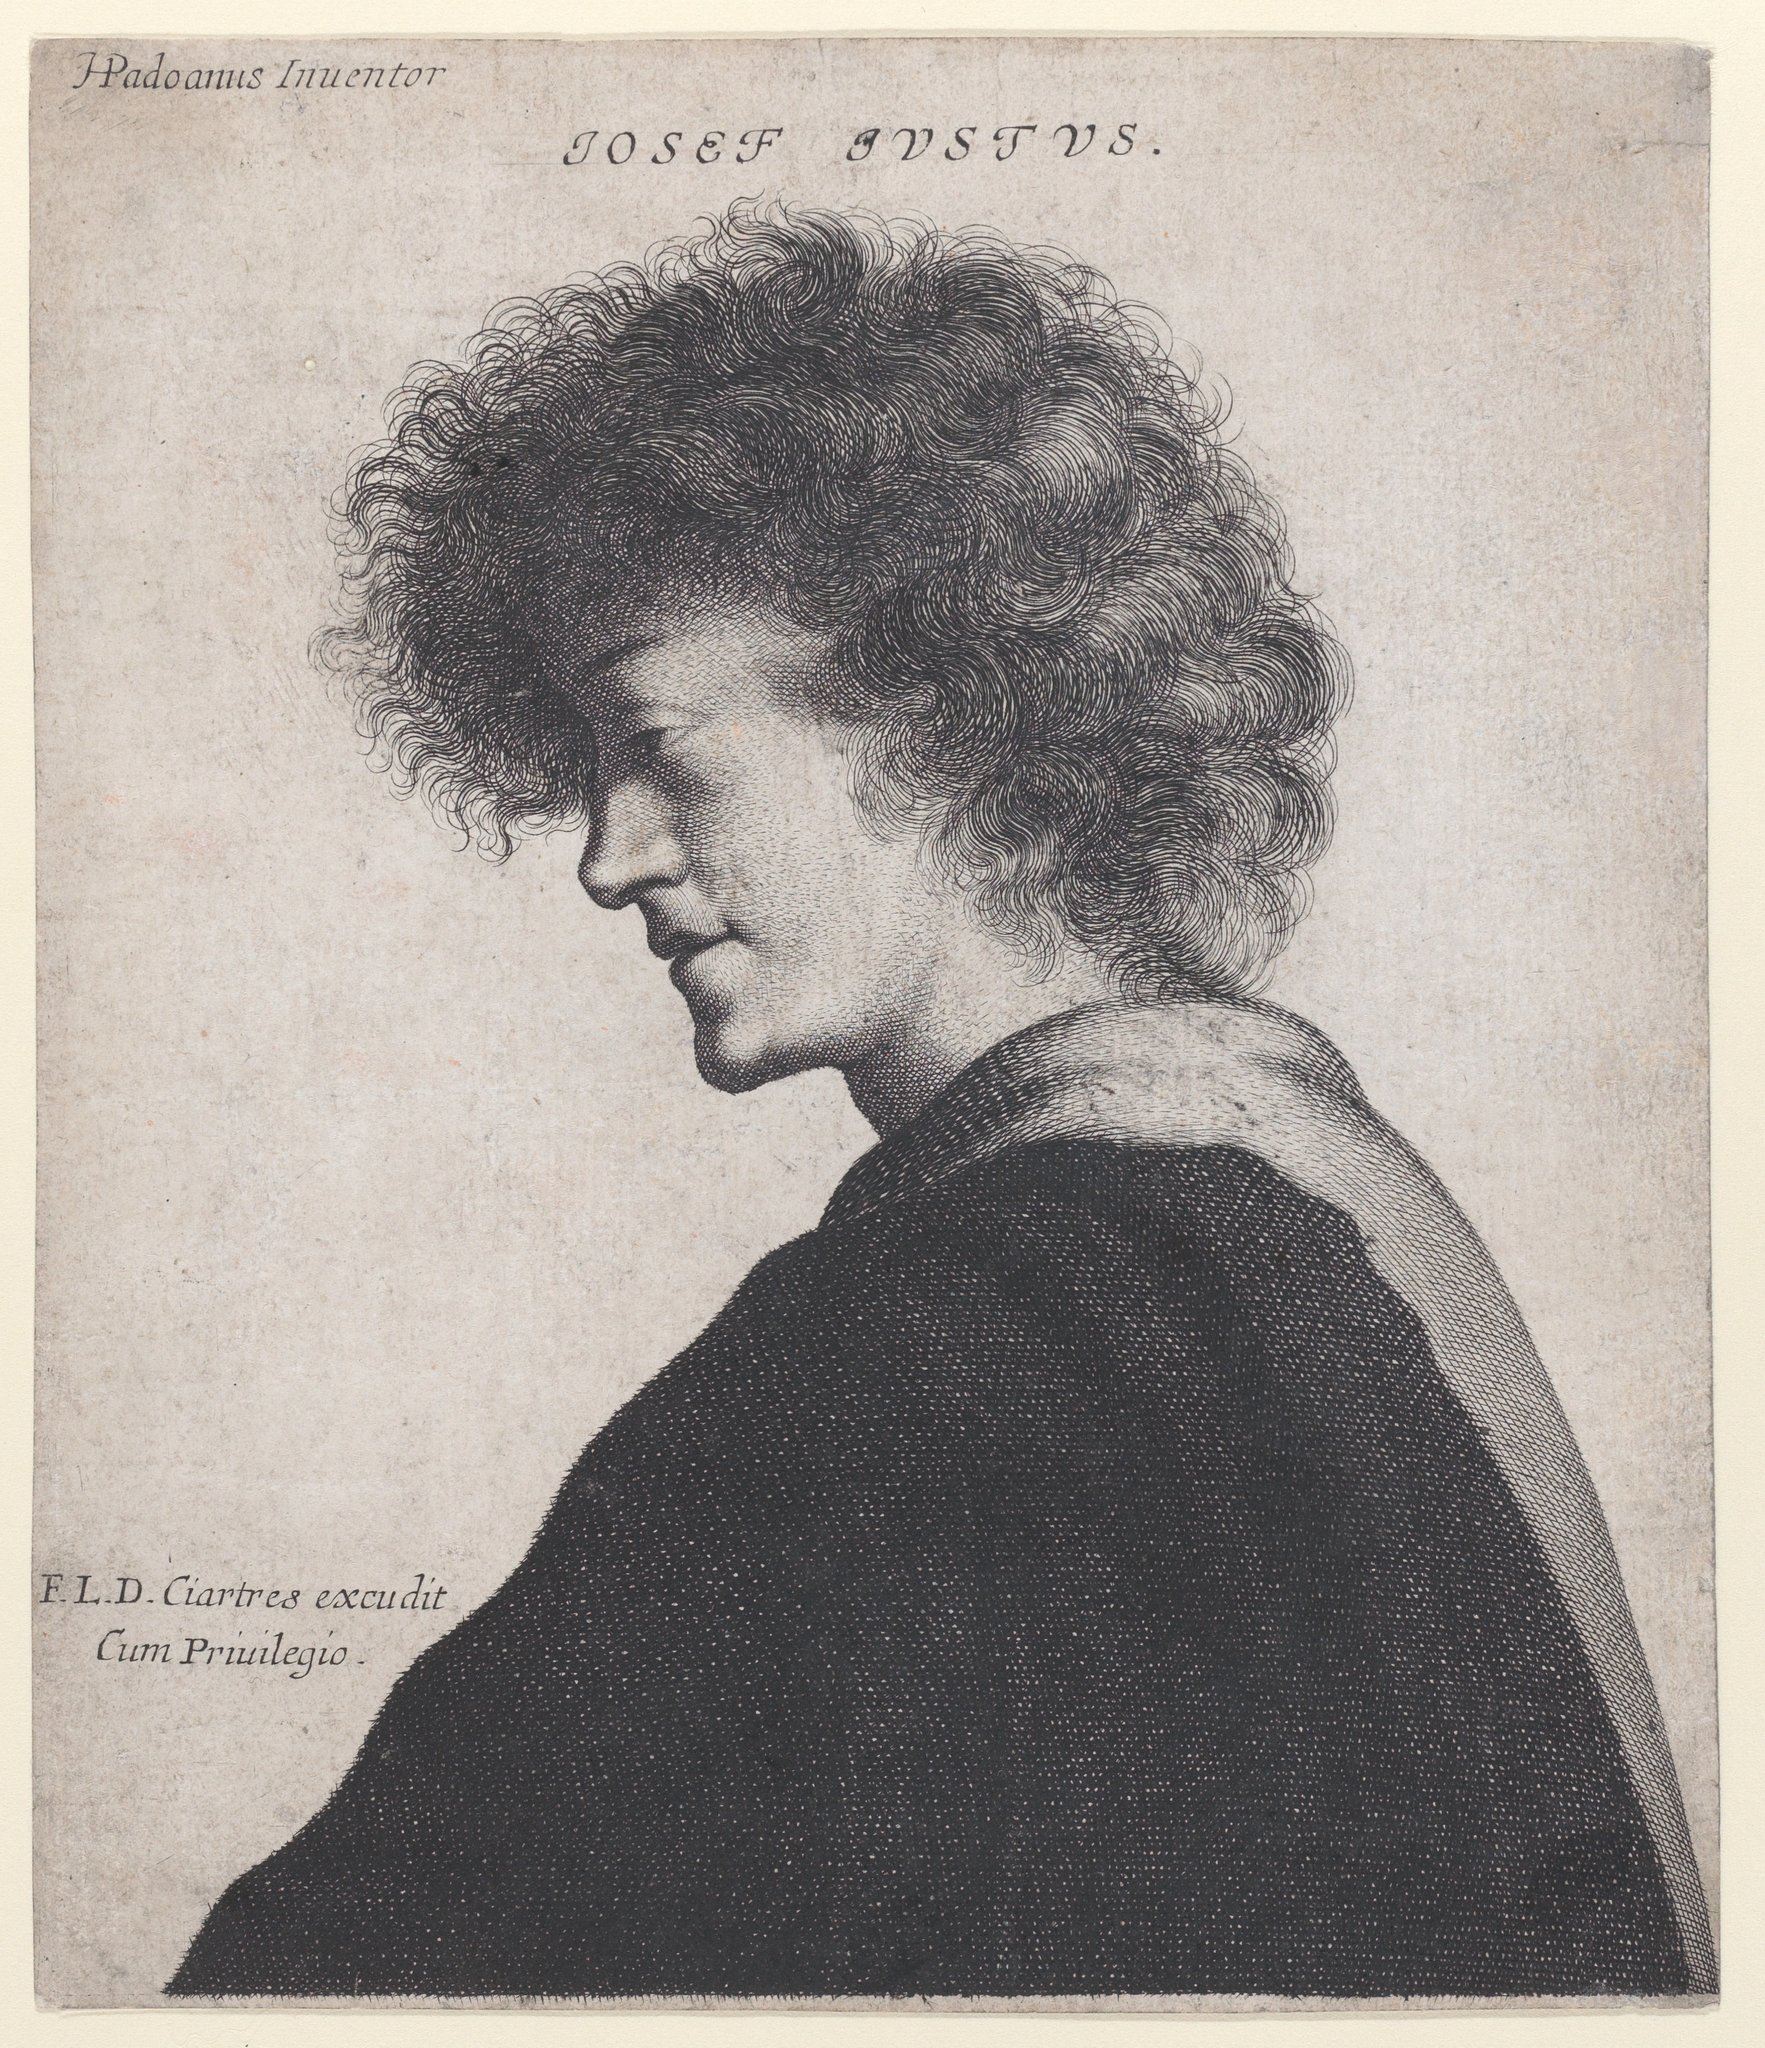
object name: print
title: Josef Justus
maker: jerôme david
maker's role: artist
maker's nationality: french?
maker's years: 1605-1670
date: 1625-1670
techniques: engraving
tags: men,portraits,profiles